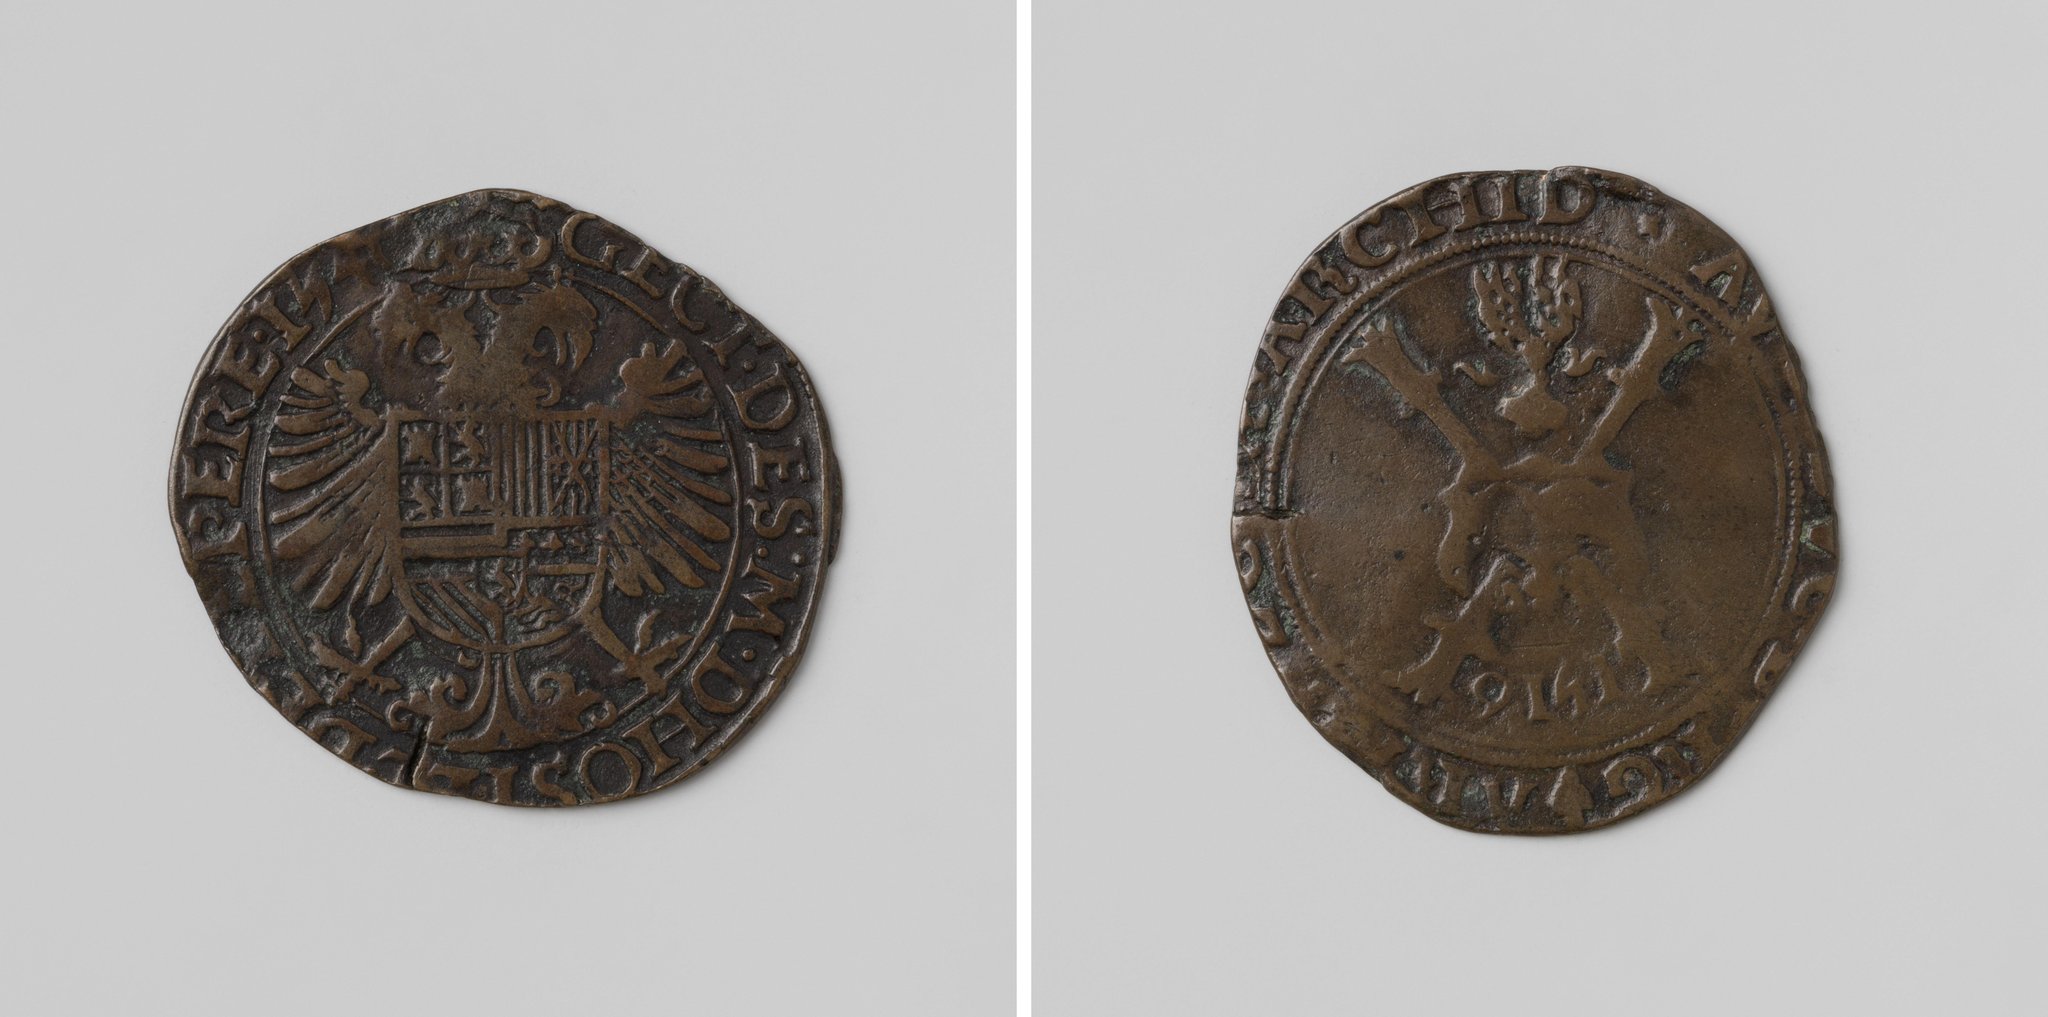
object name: jeton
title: Karel V, Duits keizer, rekenpenning van de hofmeester van de keizer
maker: Anonymous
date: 1516-1540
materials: copper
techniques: striking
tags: ghent, charles v (holy roman emperor and king of spain)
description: Koperen penning. Voorzijde: tweekoppige adelaar onder kroon met wapenschild binnen omschrift. Keerzijde: vuurslag, waaraan Gulden Vlies hangt op Bourgondisch kruis onder jaartal binnen omschrift